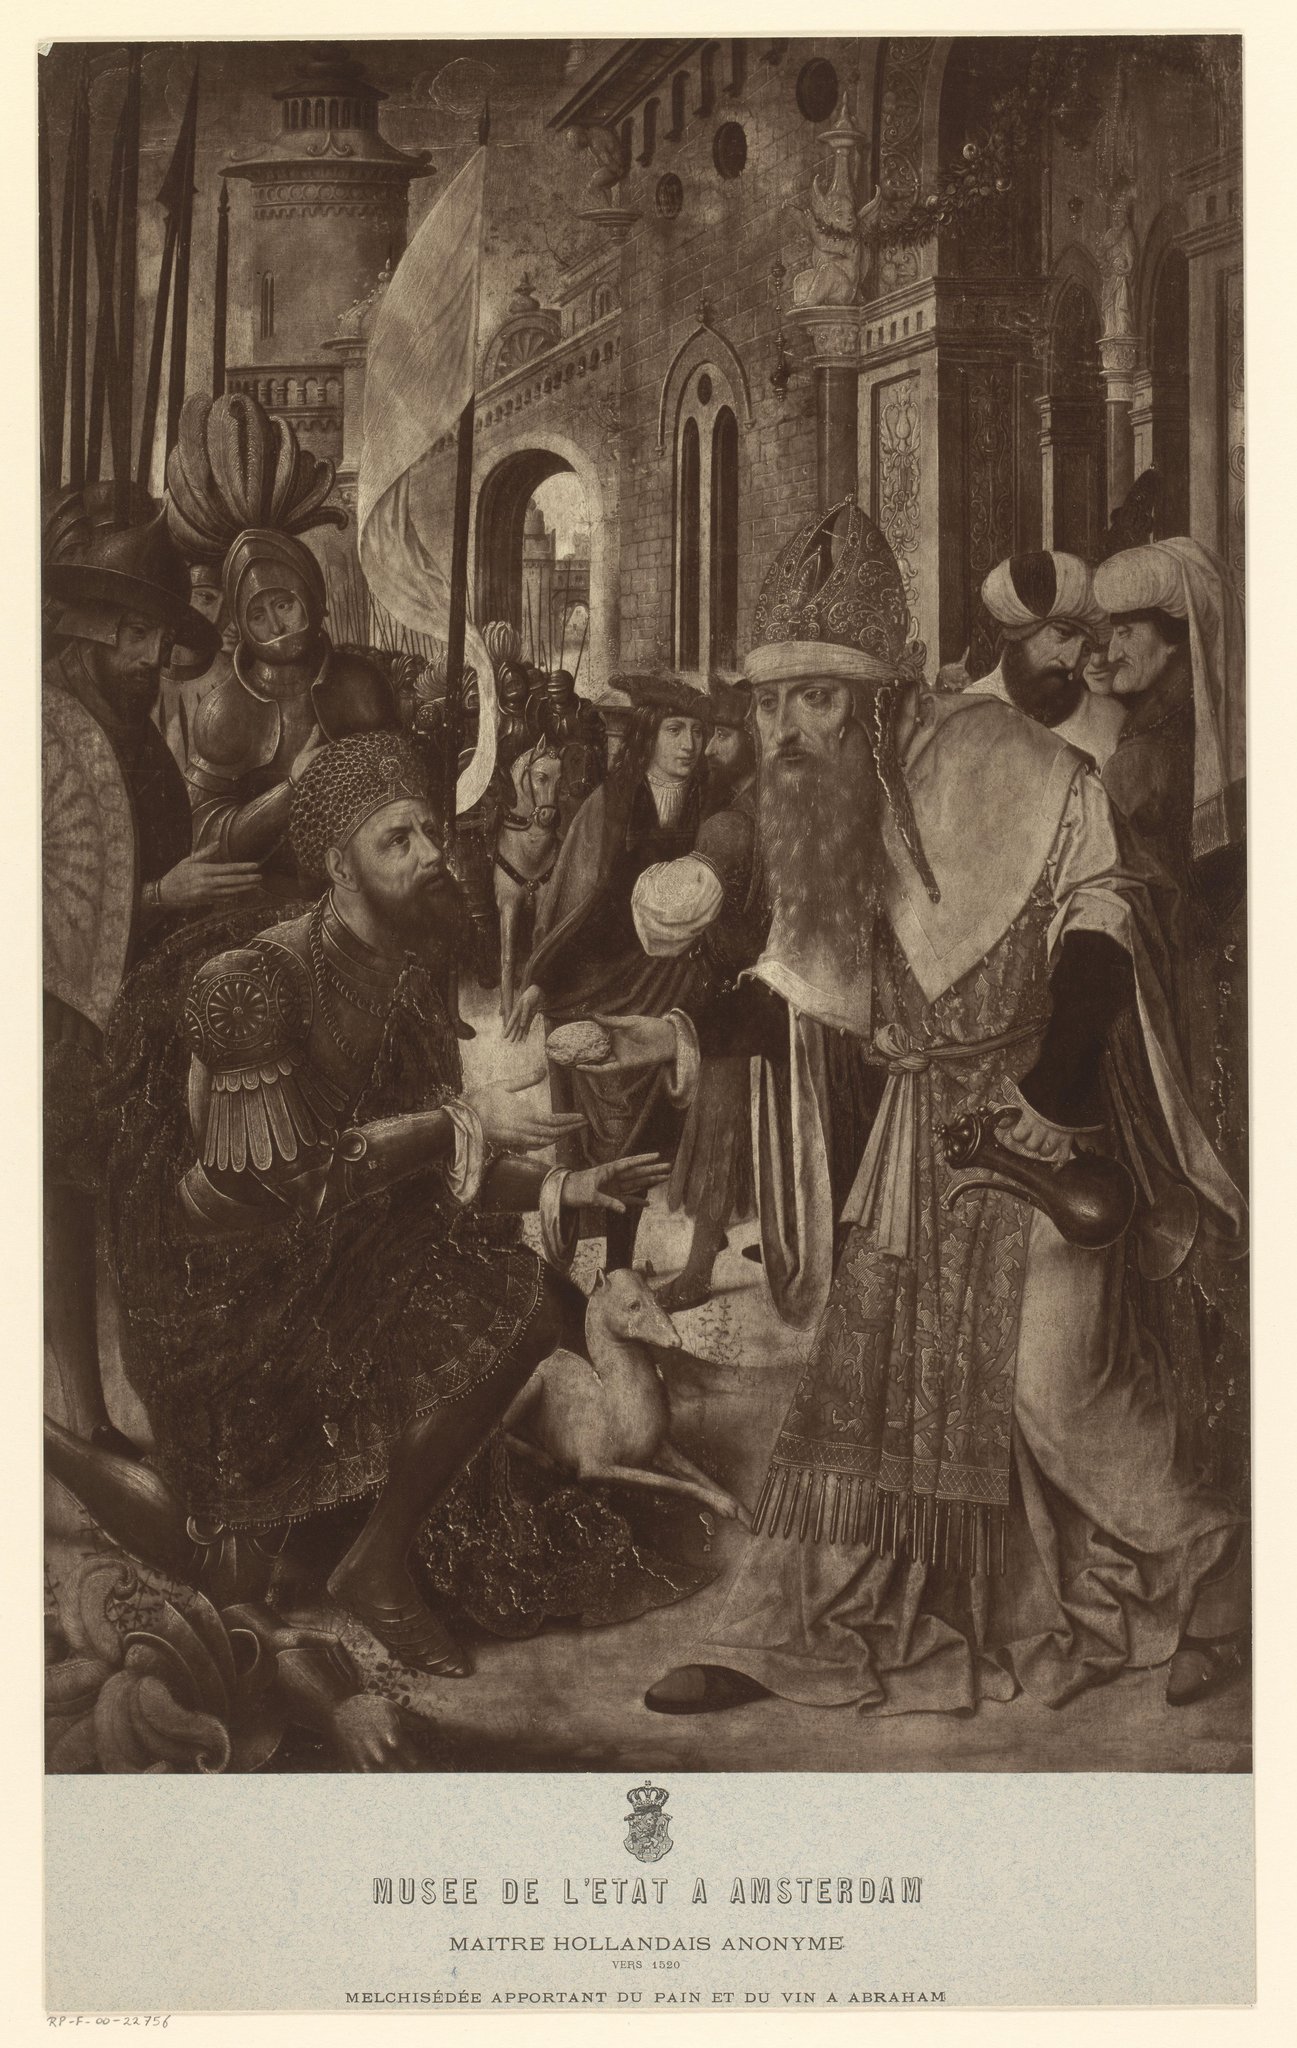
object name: photograph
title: Melchisédée apportant du pain et du vin à Abraham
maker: Anonymous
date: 1891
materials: cardboard, paper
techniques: carbon print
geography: dornach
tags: the meeting of abraham and melchizedek, the high priest and king of salem, who brings bread and wine (genesis 14:18-20)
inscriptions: inscription: ‘Maitre hollandais anonyme/ vers 1520’, stamp: ‘ICON’